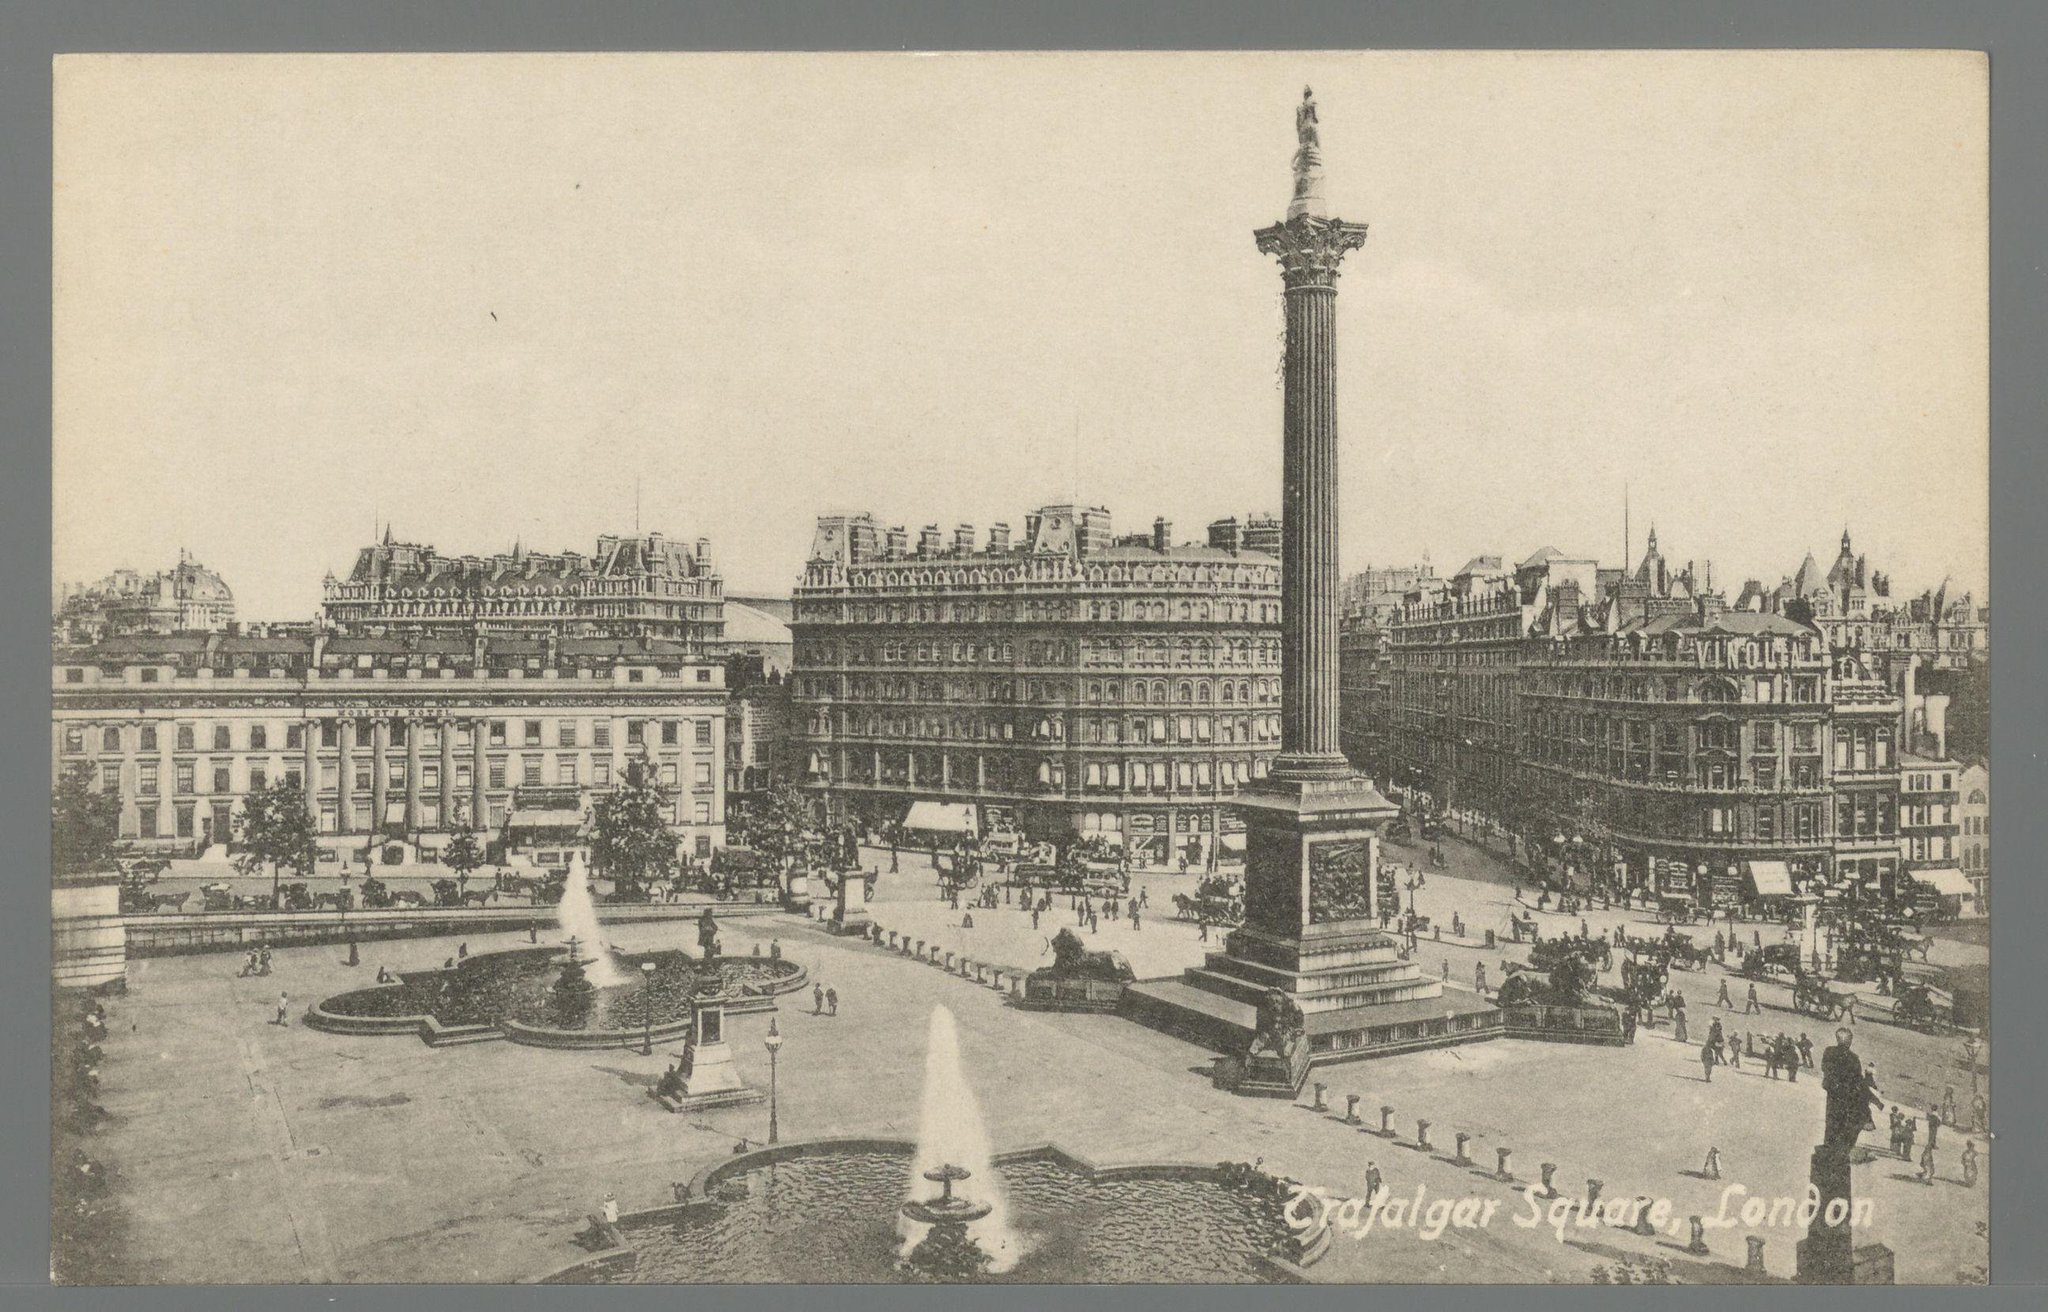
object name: photomechanical print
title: Valentine's Series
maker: Anonymous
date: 1902-1930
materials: cardboard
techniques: photograph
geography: dundee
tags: horatio nelson (hertog van bronte), square, place, circus, etc., monument, statue